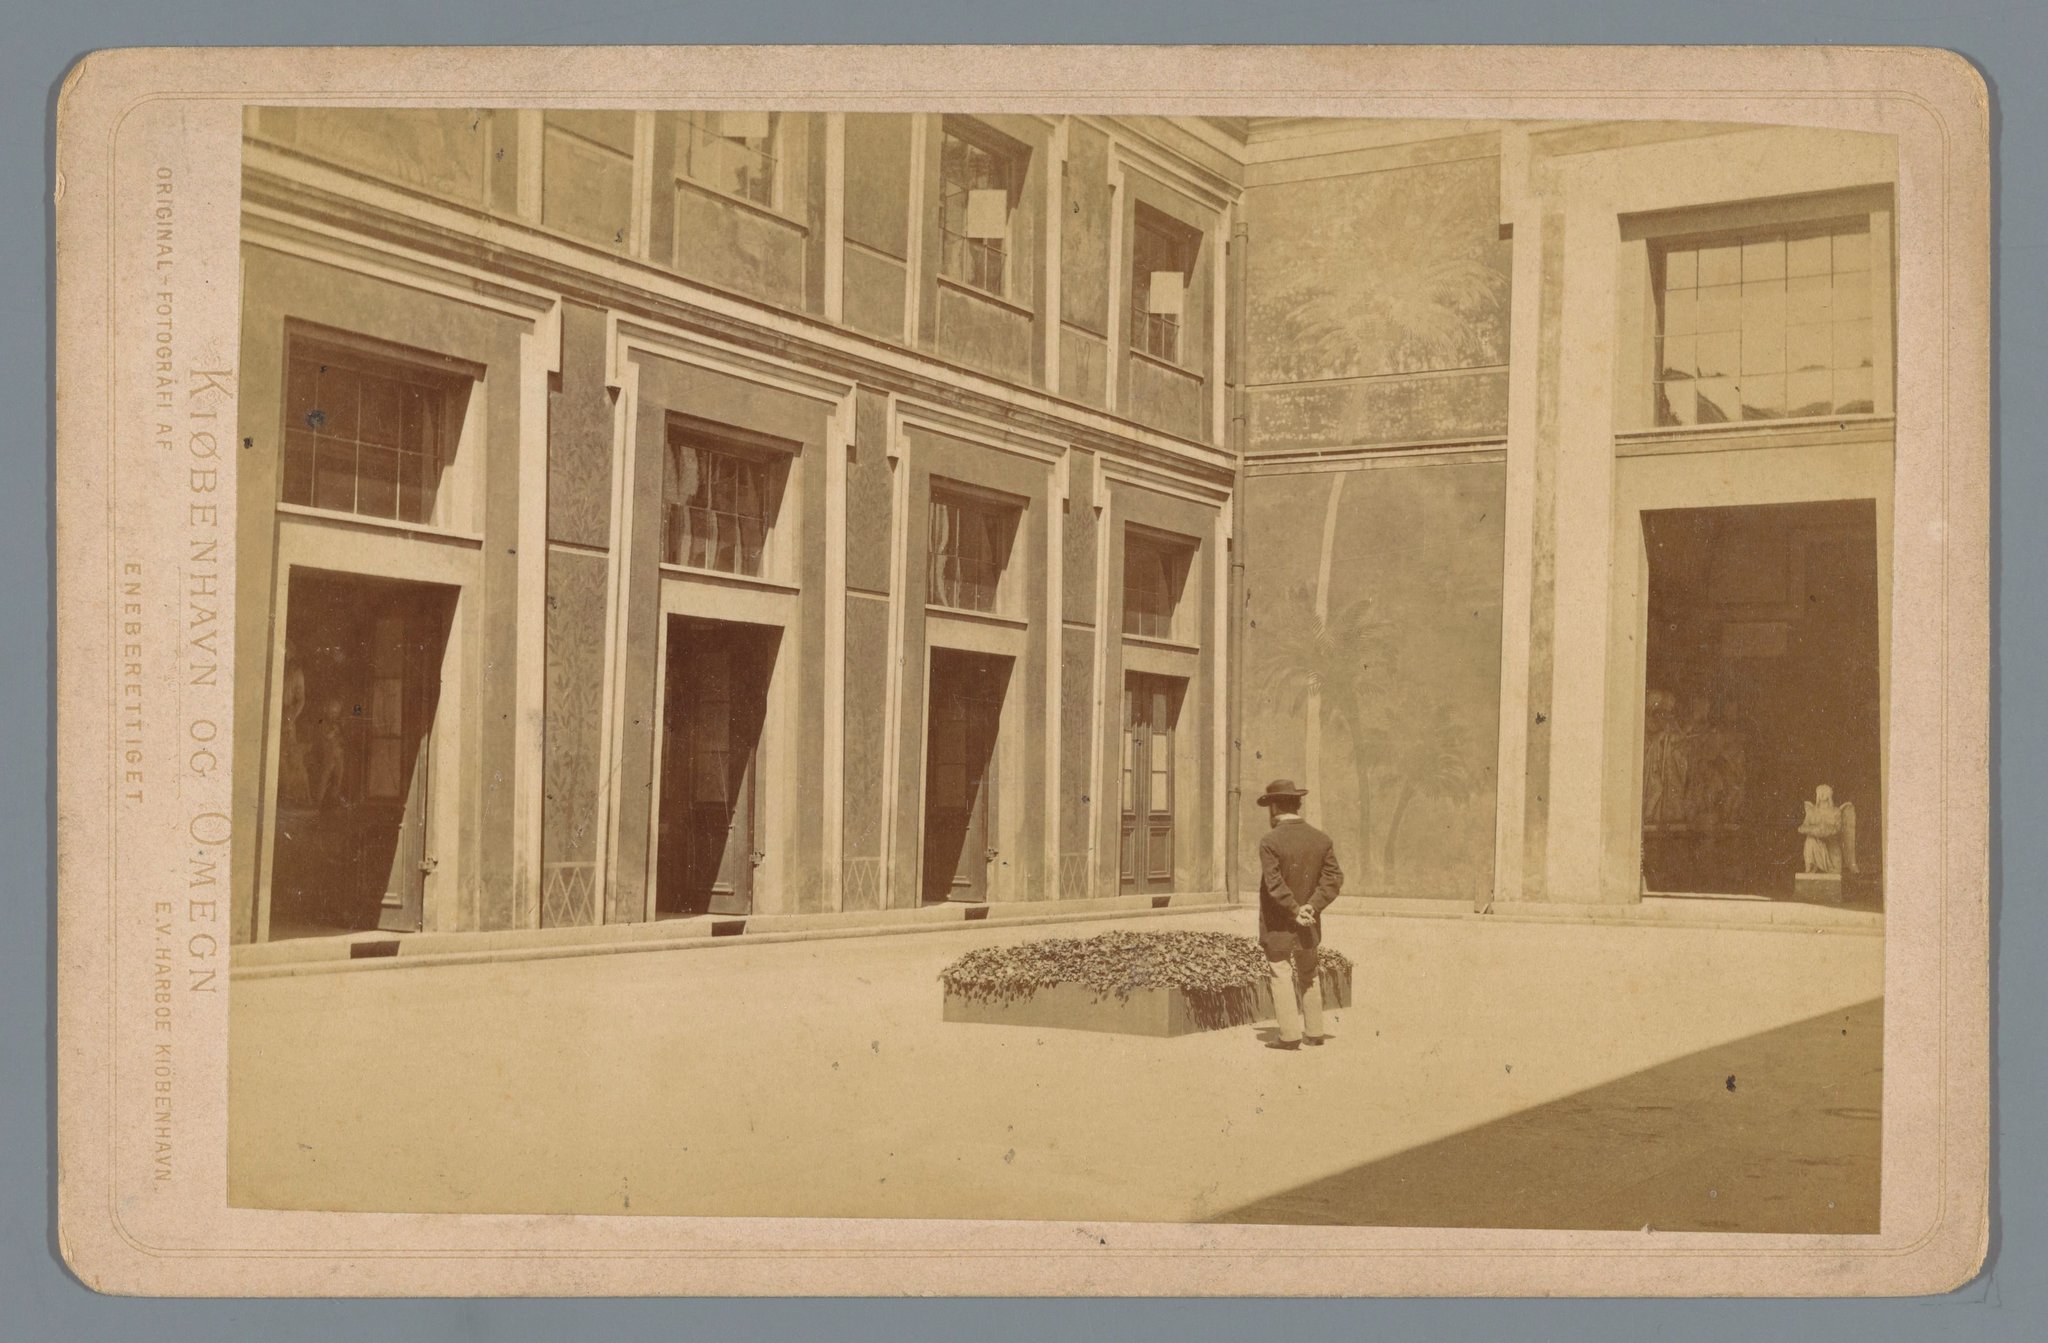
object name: cabinet photograph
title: Kiobenhavn og Omeng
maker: edvard valdemar harboe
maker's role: fotograaf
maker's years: 1834-1883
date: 1854-1883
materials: cardboard, photographic support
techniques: albumen print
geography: copenhagen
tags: grave, tomb, permanent exhibition, museum, copenhagen (city)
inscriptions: retailer's mark: ‘34/ Kongens Nytorv/ Hotel d'Angleterre/ Emil Bergmann/ Bog & Papirhandel/ Kiobenhavn.’, inscription: ‘original-fotografi af E.V. Harboe Kiobenhavn/ eneberettiget.’